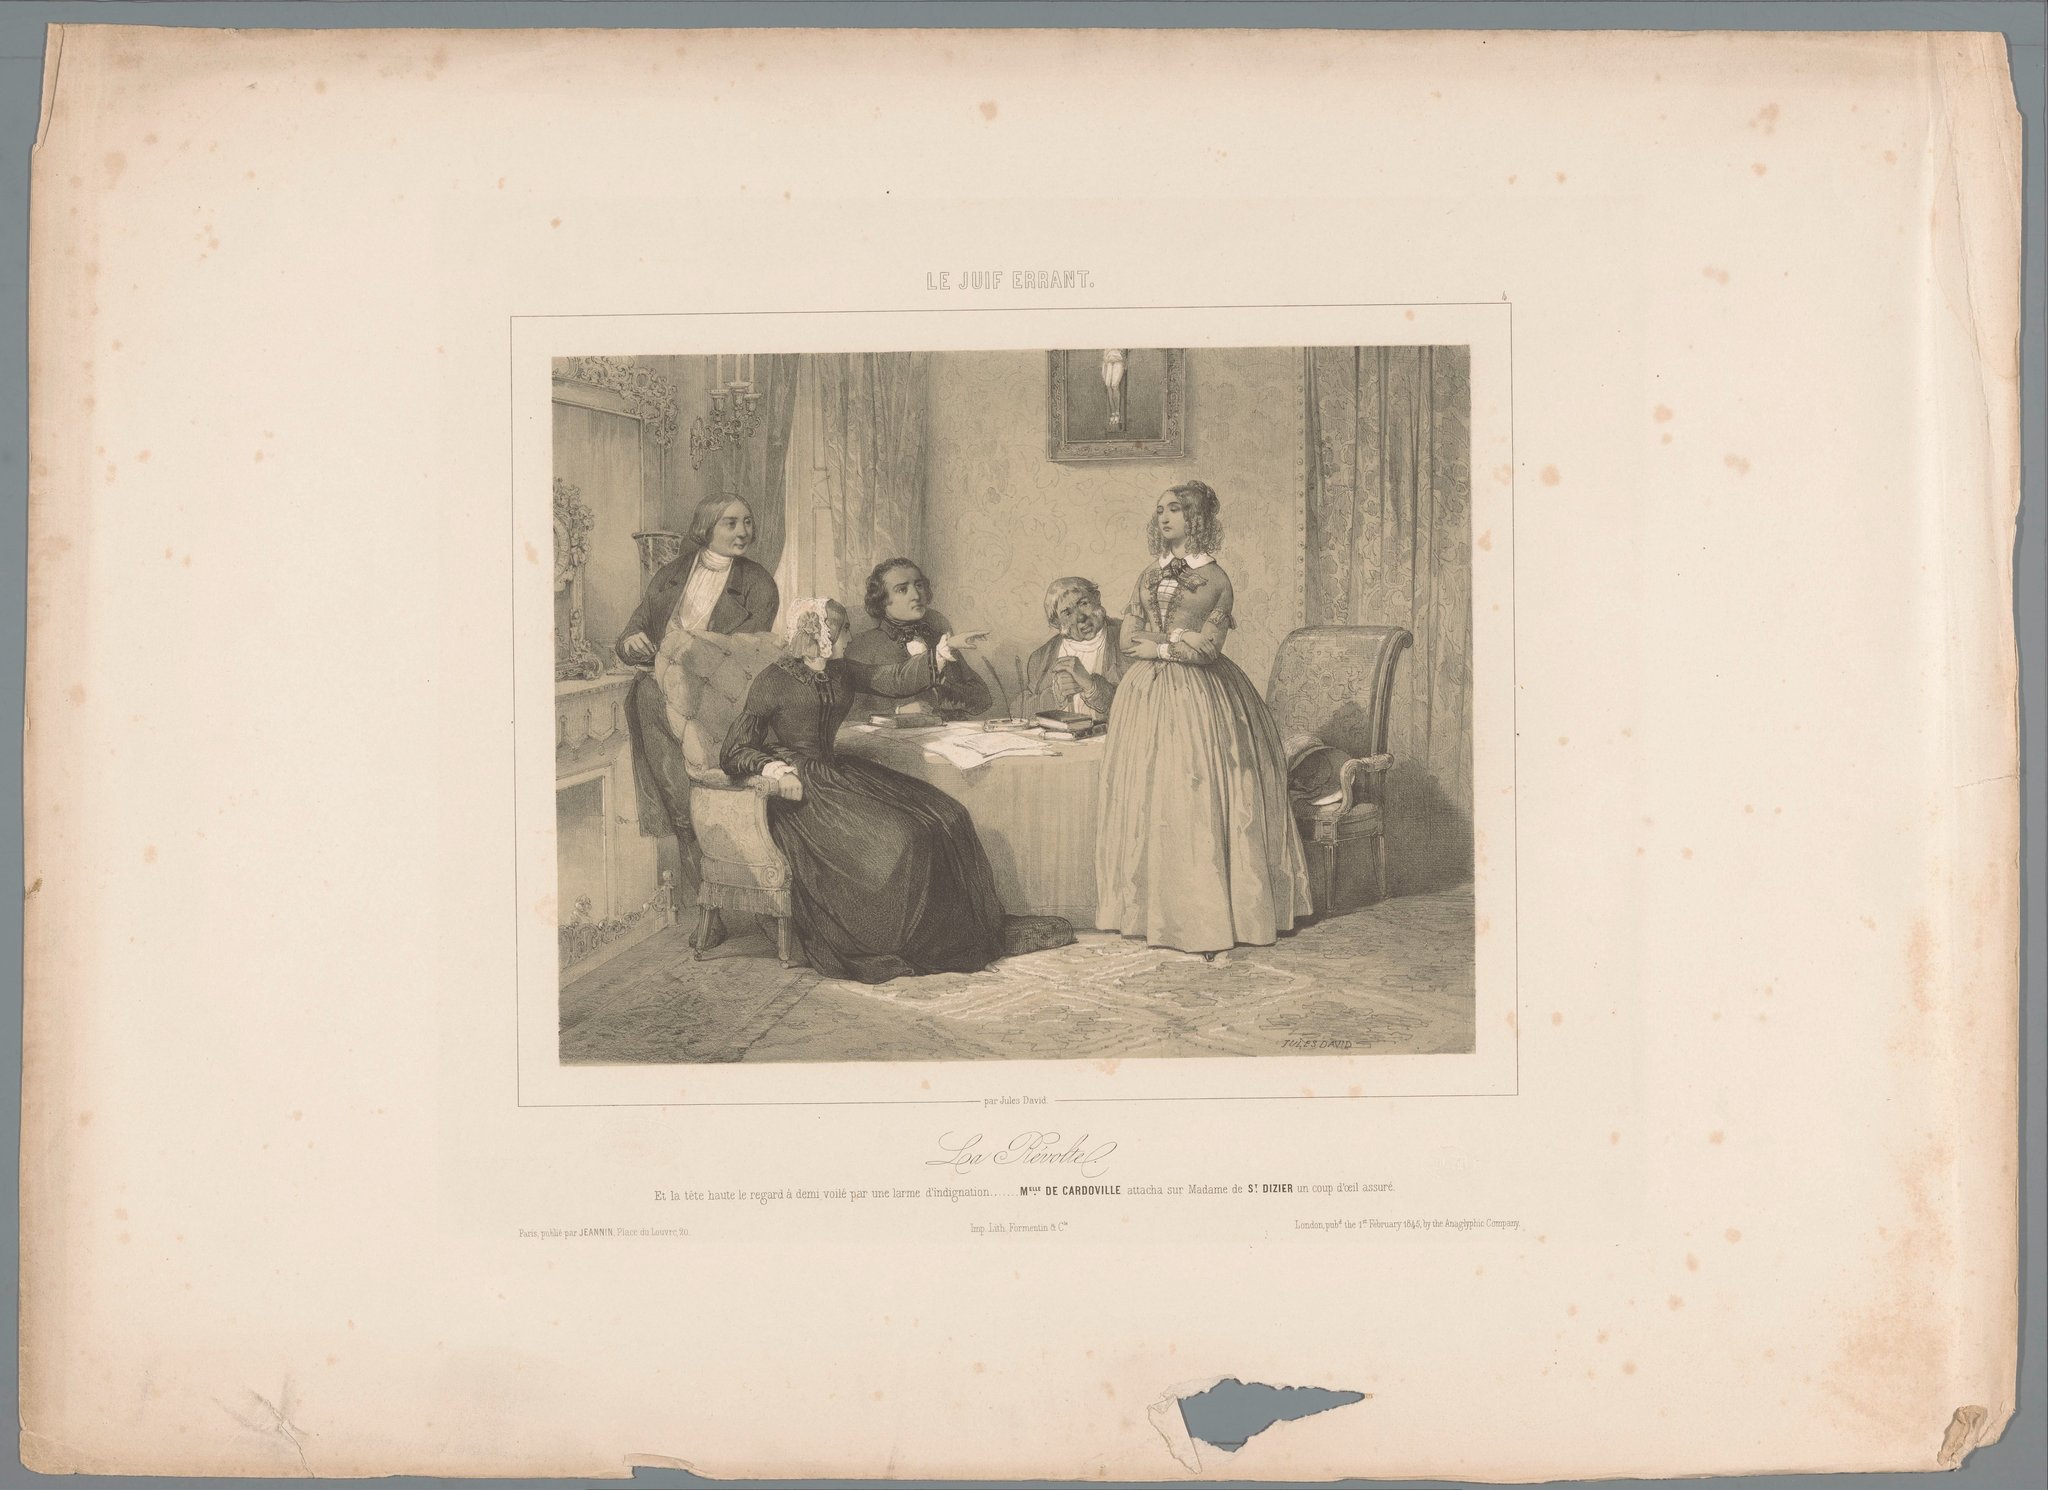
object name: print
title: Adrienne de Cardoville komt in opstand tegen haar tante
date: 1844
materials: paper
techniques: tone lithography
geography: paris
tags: adolescent, young woman, maiden, uncles, aunts (third degree family relationships), interior of the house, accusing, paris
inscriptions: check stamp: Lugt 1397c, check stamp: Lugt 3903, collector's mark: Lugt 2228a